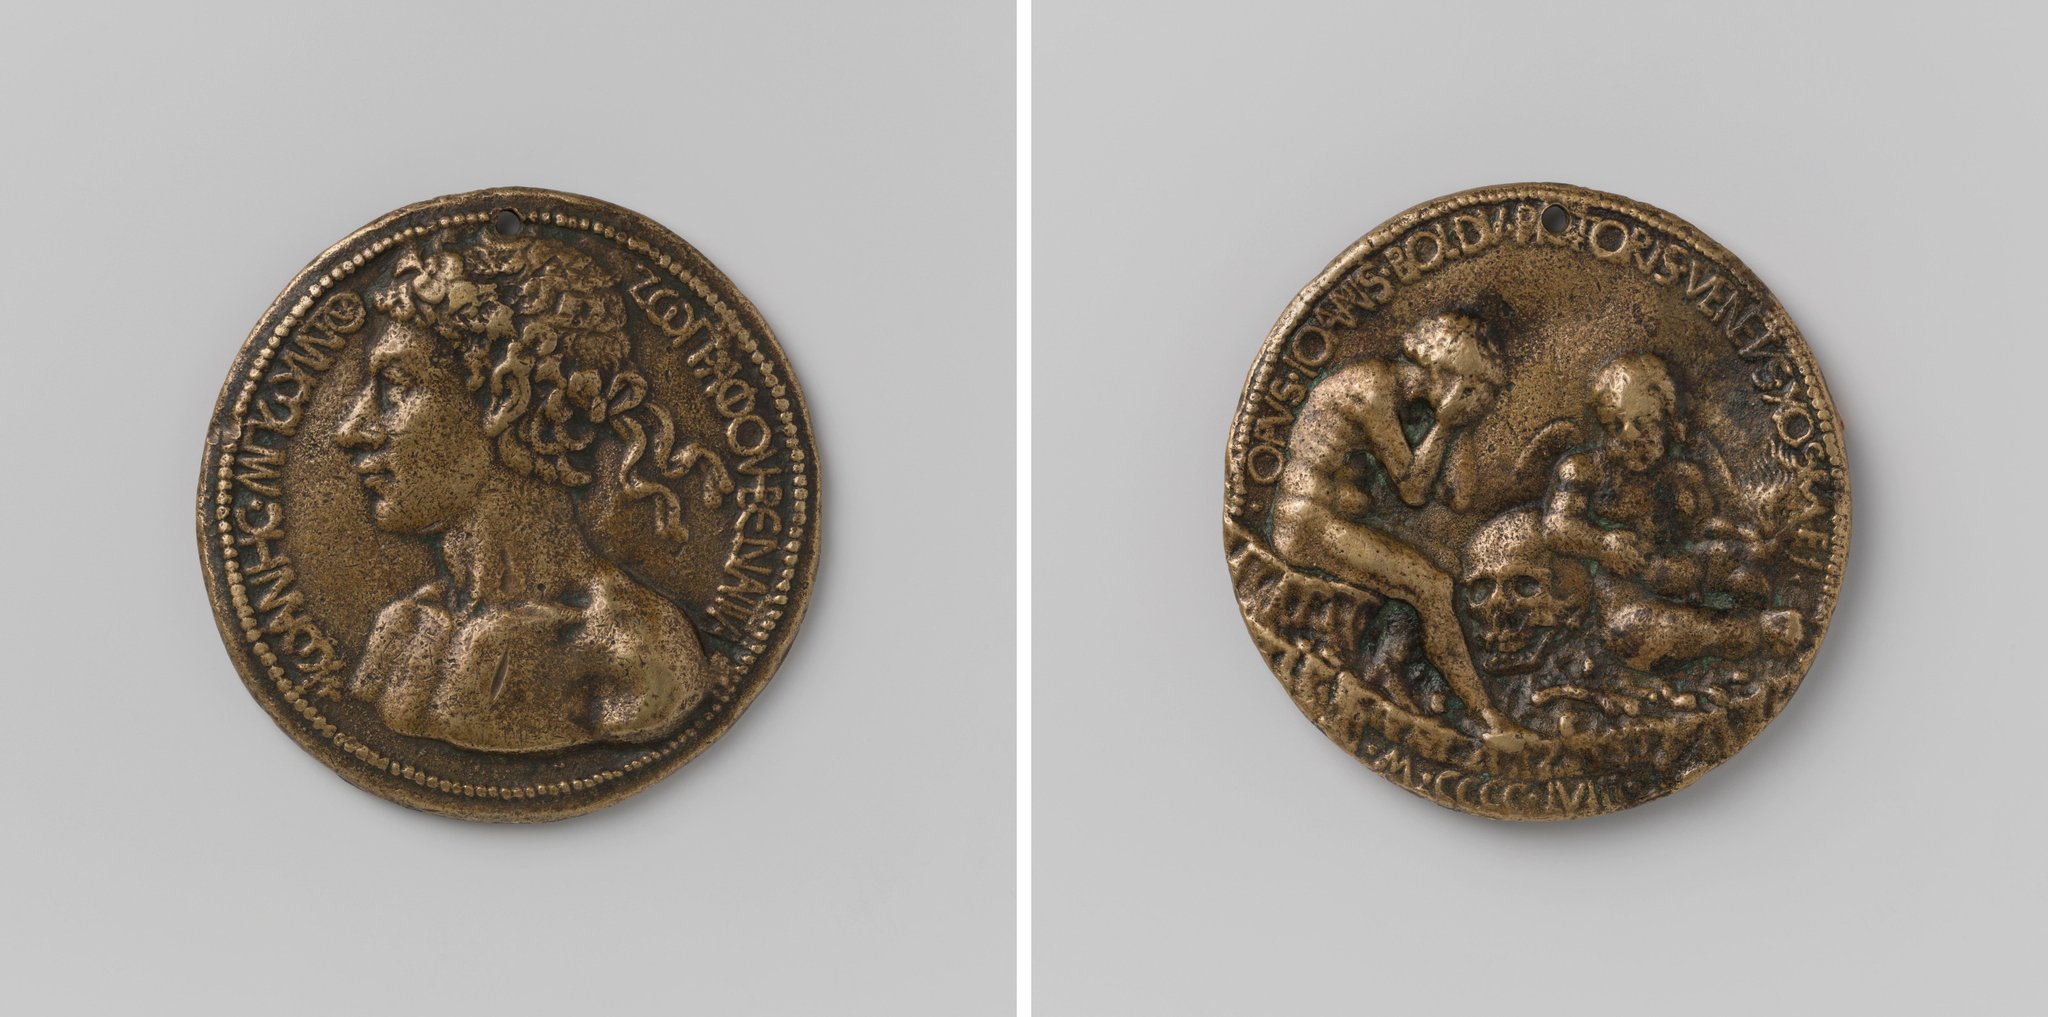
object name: history medal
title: Giovanni Boldu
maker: giovanni boldu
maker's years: 1454-1477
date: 1458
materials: bronze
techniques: casting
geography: venice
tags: giovanni boldu, venice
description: Bronzen penning met gat erin. Voorzijde: borststuk man met krans in haar naar links binnen omschrift in Griekse taal. Keerzijde: twee engeltjes zittend bij doodshoofd binnen omschrift.